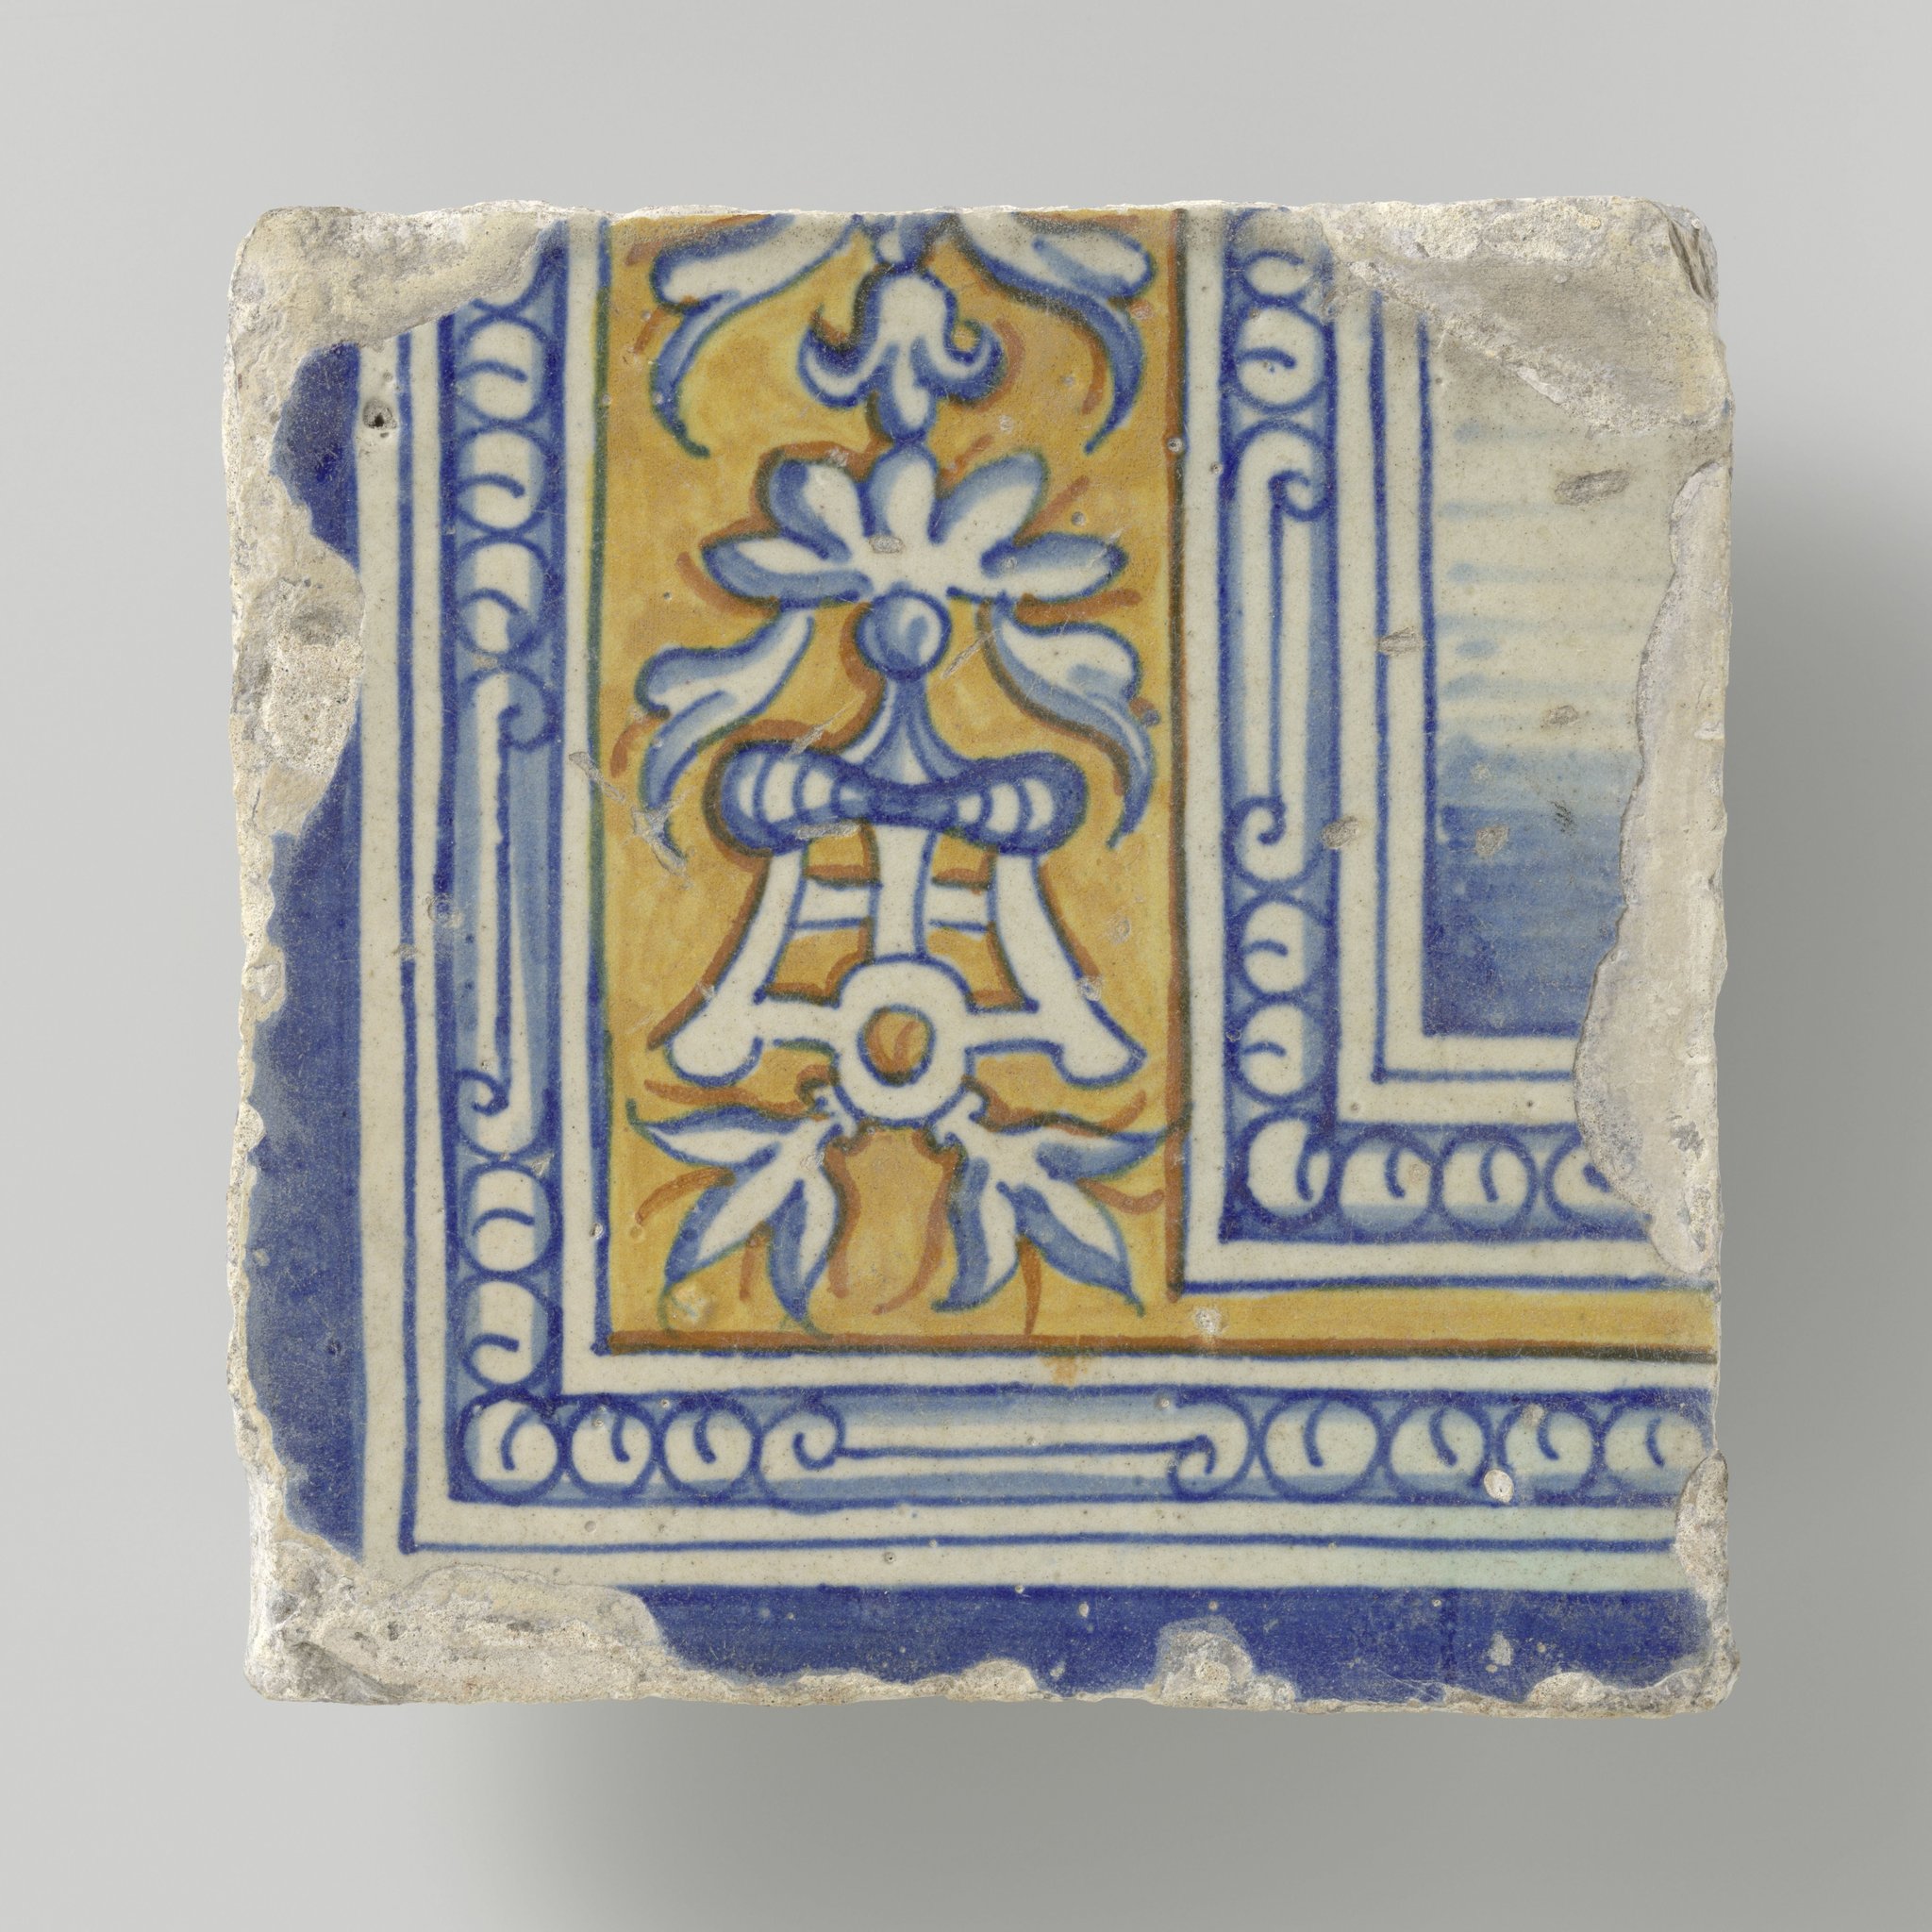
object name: tile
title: Randtegel van een tegeltableau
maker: Anonymous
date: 1550-1600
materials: earthenware, glaze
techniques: maiolica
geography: antwerp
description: Randtegel voor een hoek van een tegeltableau, beschilderd in blauw, groen, geel en oranje met rolwerk-motieven tussen een parellijst.